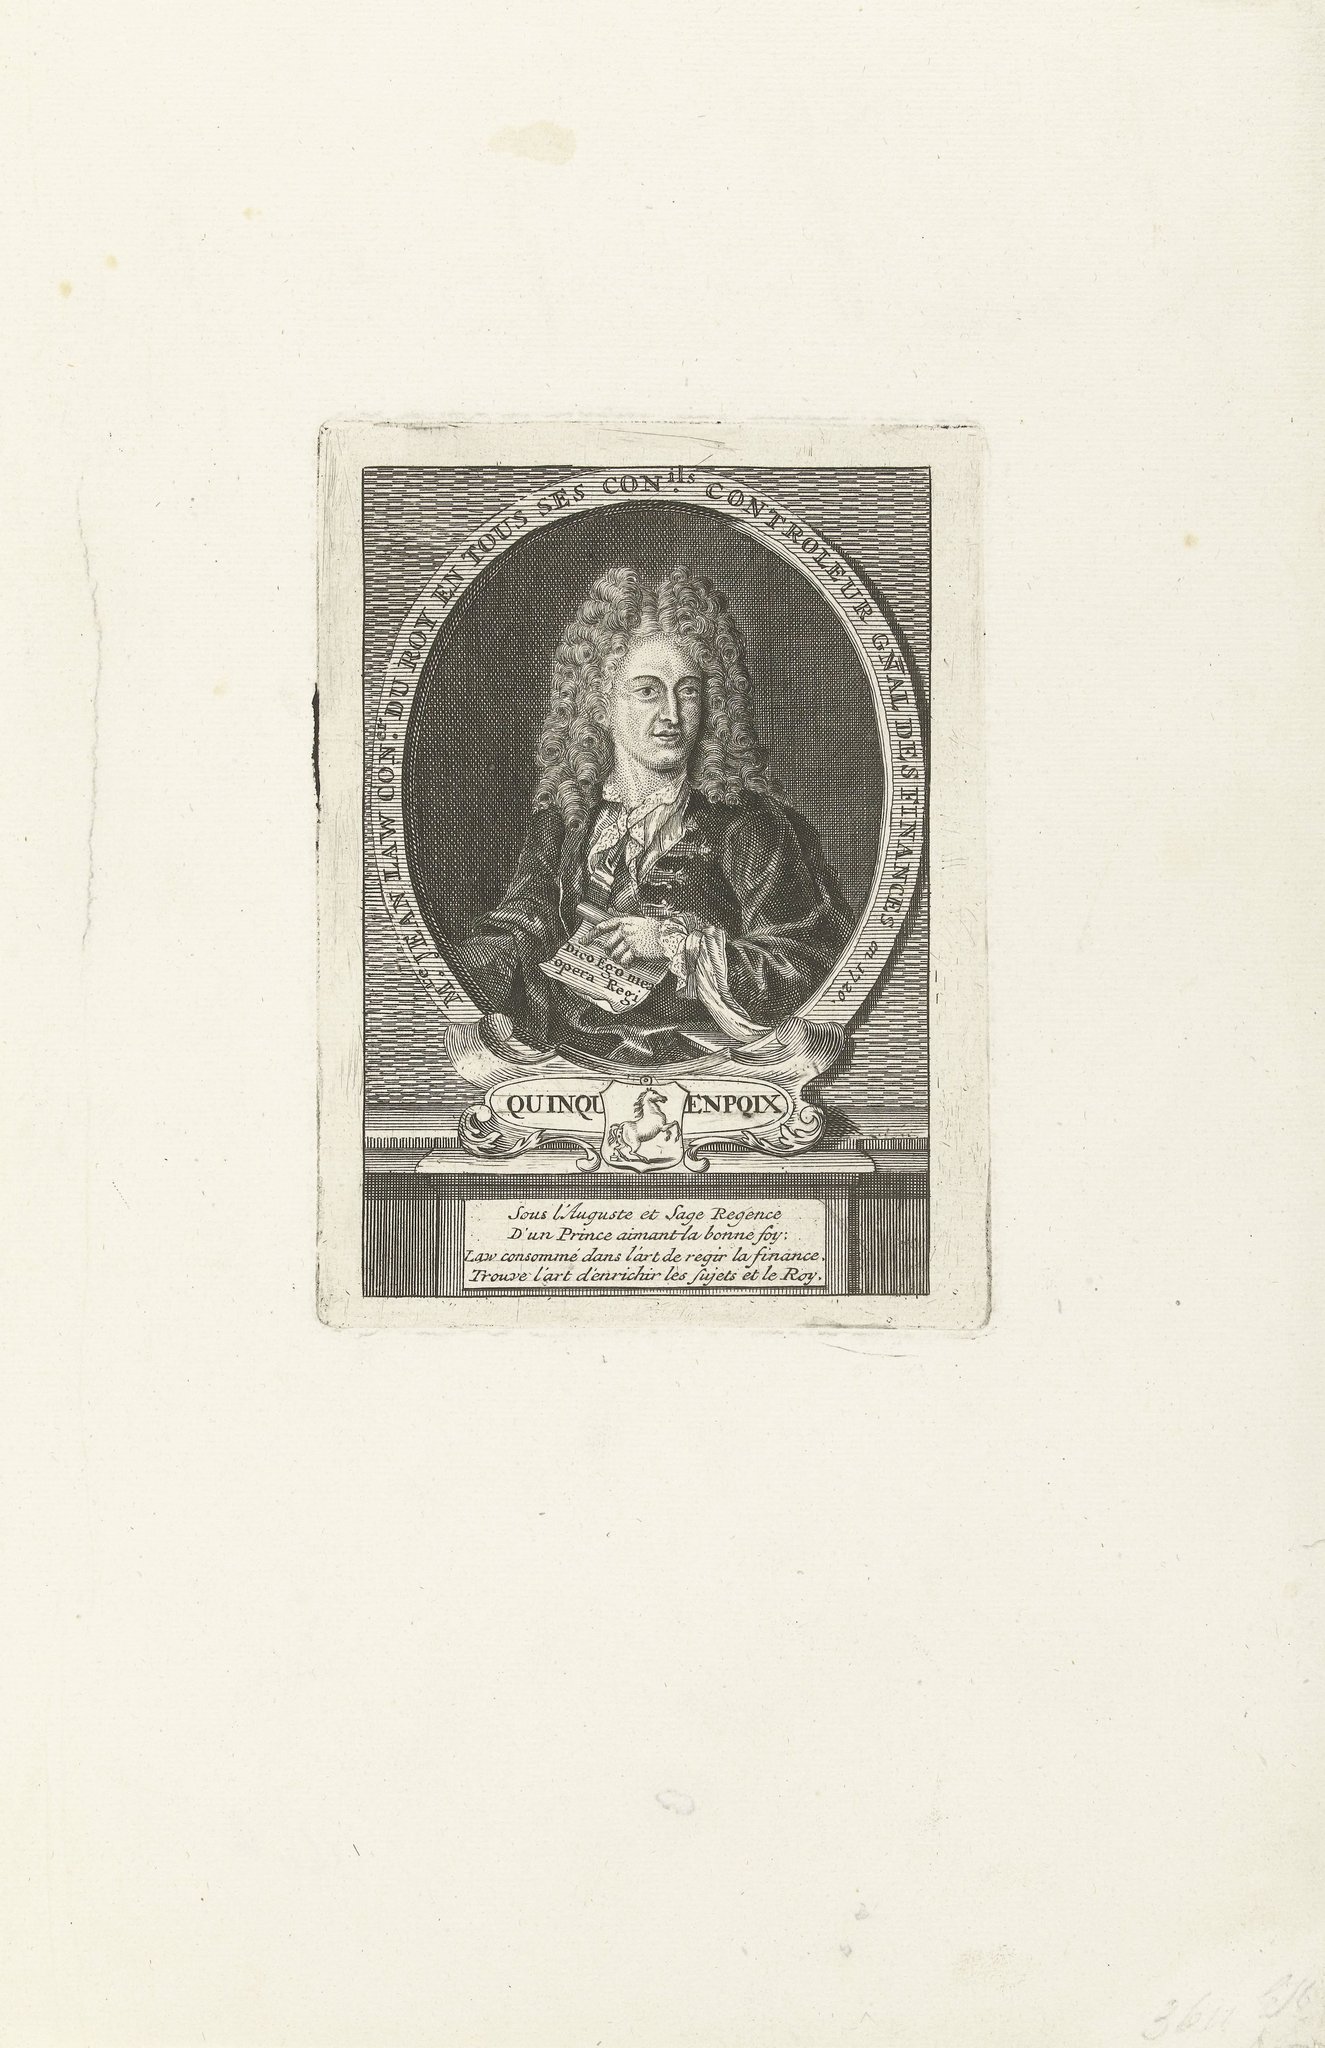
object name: print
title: Het Groote Tafereel der Dwaasheid (extra stukken)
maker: hendrik de leth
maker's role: draughtsman, print maker, publisher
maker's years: 1703-1766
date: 1720-1766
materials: paper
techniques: engraving, etching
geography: northern netherlands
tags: econoom, john law, windhandel van 1720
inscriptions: collector's mark: Lugt 2228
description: Ovaal portret van John Law in medaillon, ten halven lijve, naar rechts, ca. 1720. Met randschrift en onderschrift in het Frans. Onder het portret een wapen met een paard en het opschrift: Quinquenpoix. Behoort tot de groep van bijprenten toegevoegd aan de serie Tafereel der Dwaasheid met spotprenten op de Windhandel of Actiehandel van 1720.